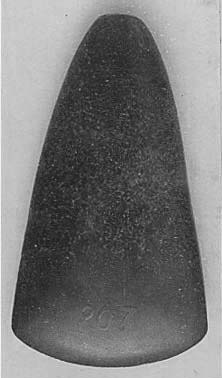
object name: hatchet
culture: french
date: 1902